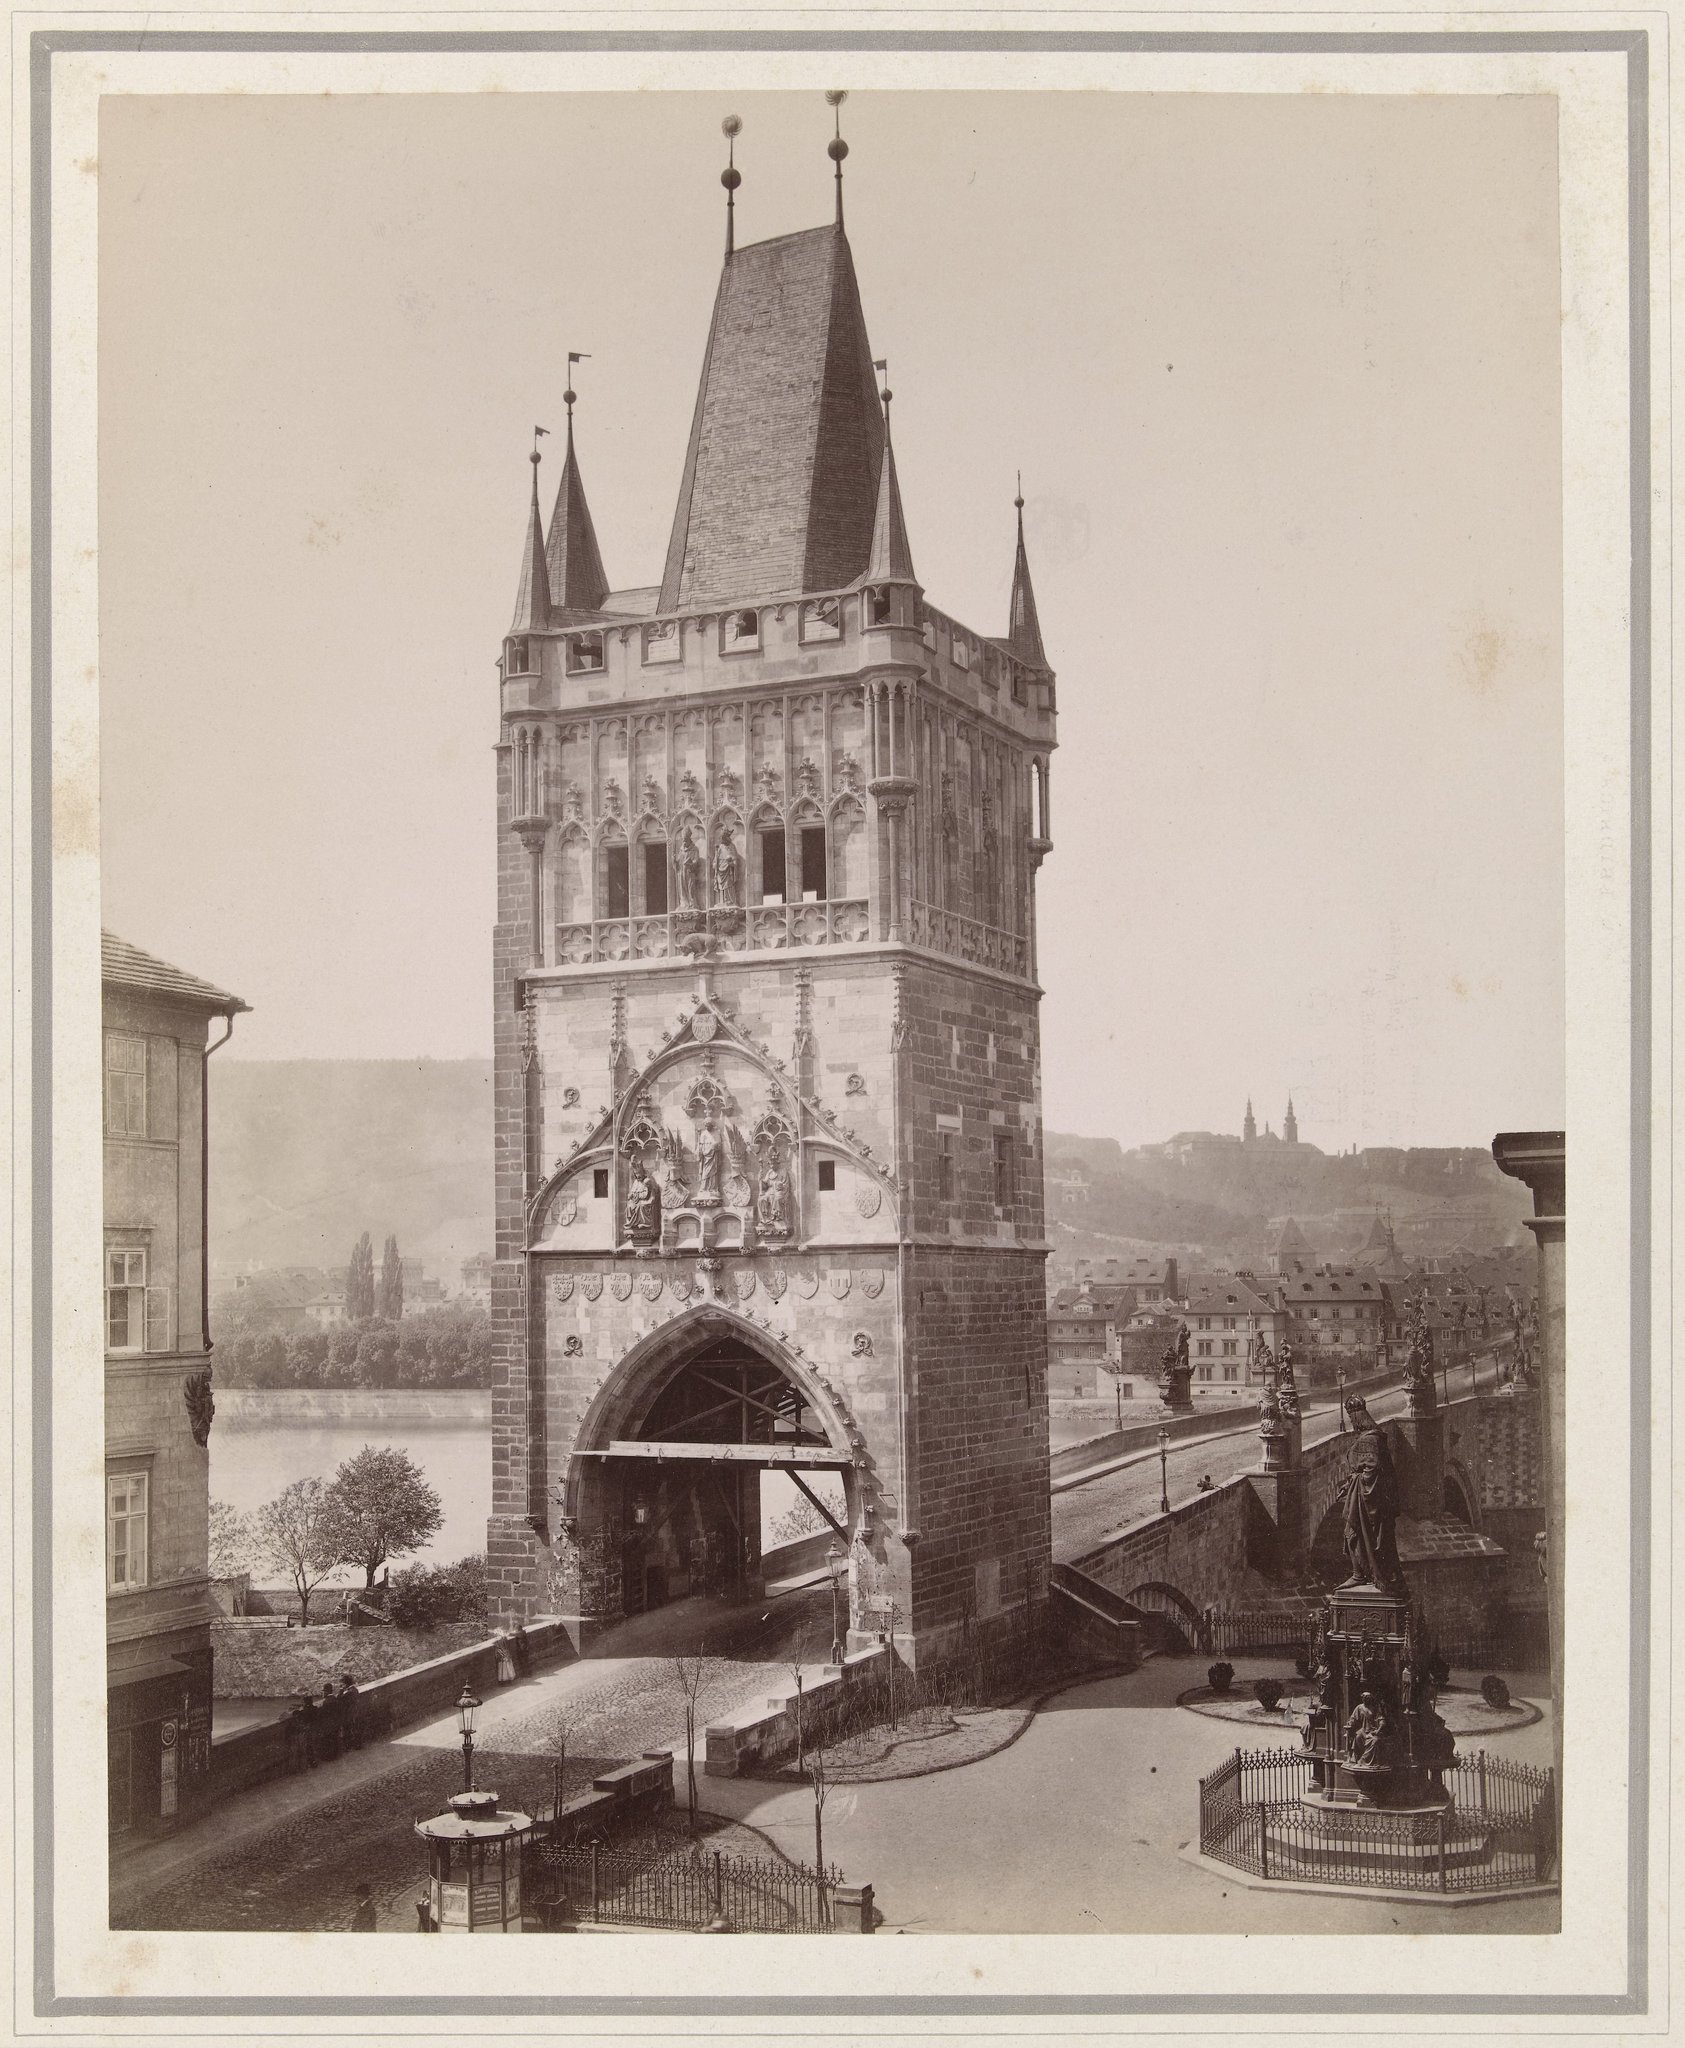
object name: photograph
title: Karelsbrug in Praag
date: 1855-1900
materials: cardboard, paper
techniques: albumen print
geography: prague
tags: bridge in city across river, canal, etc.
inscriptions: number: ‘68.’